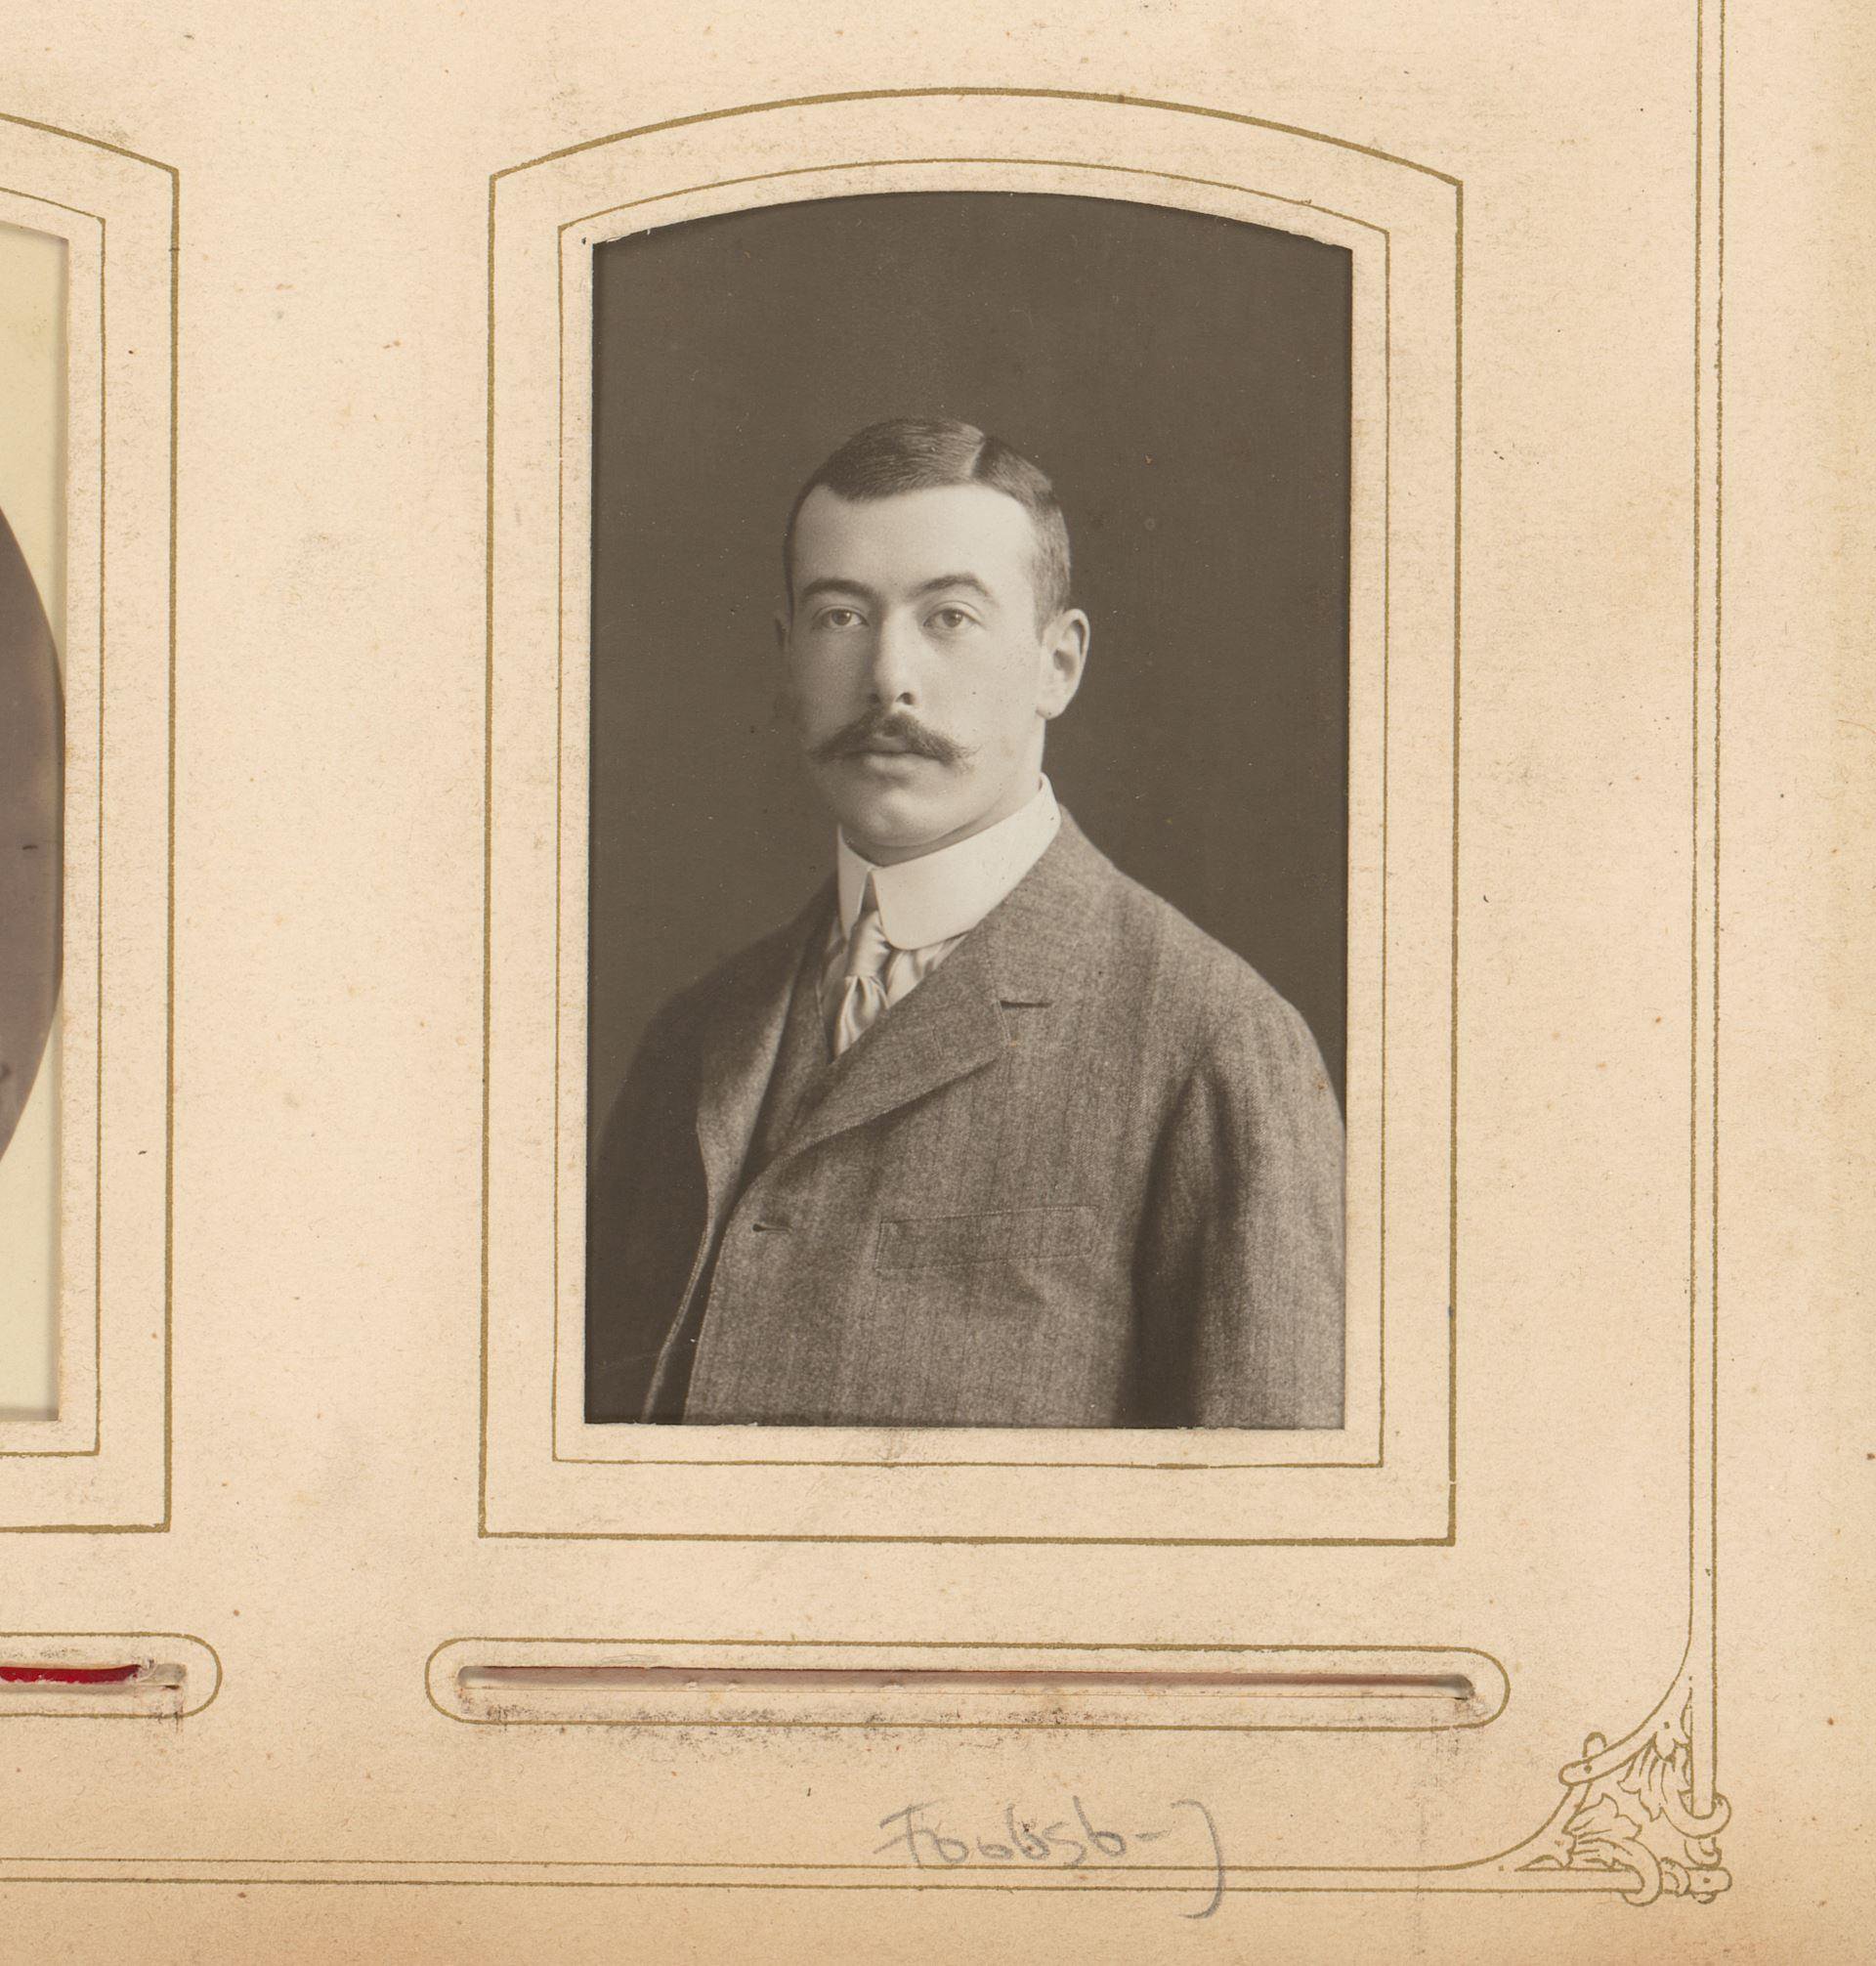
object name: photograph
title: Portret van een man met snor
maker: emile muns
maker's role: fotograaf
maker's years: 1878-1964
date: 1894-1900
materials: cardboard, photographic support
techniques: matte daylight collodion silver print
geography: netherlands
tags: moustache, historical persons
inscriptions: inscription: ‘Fotografie/ MUNS/ Spui 7 hoek Kalverstraat/ AMSTERDAM/ Arnold Hoogvlietstraat/ VLAARDINGEN.’